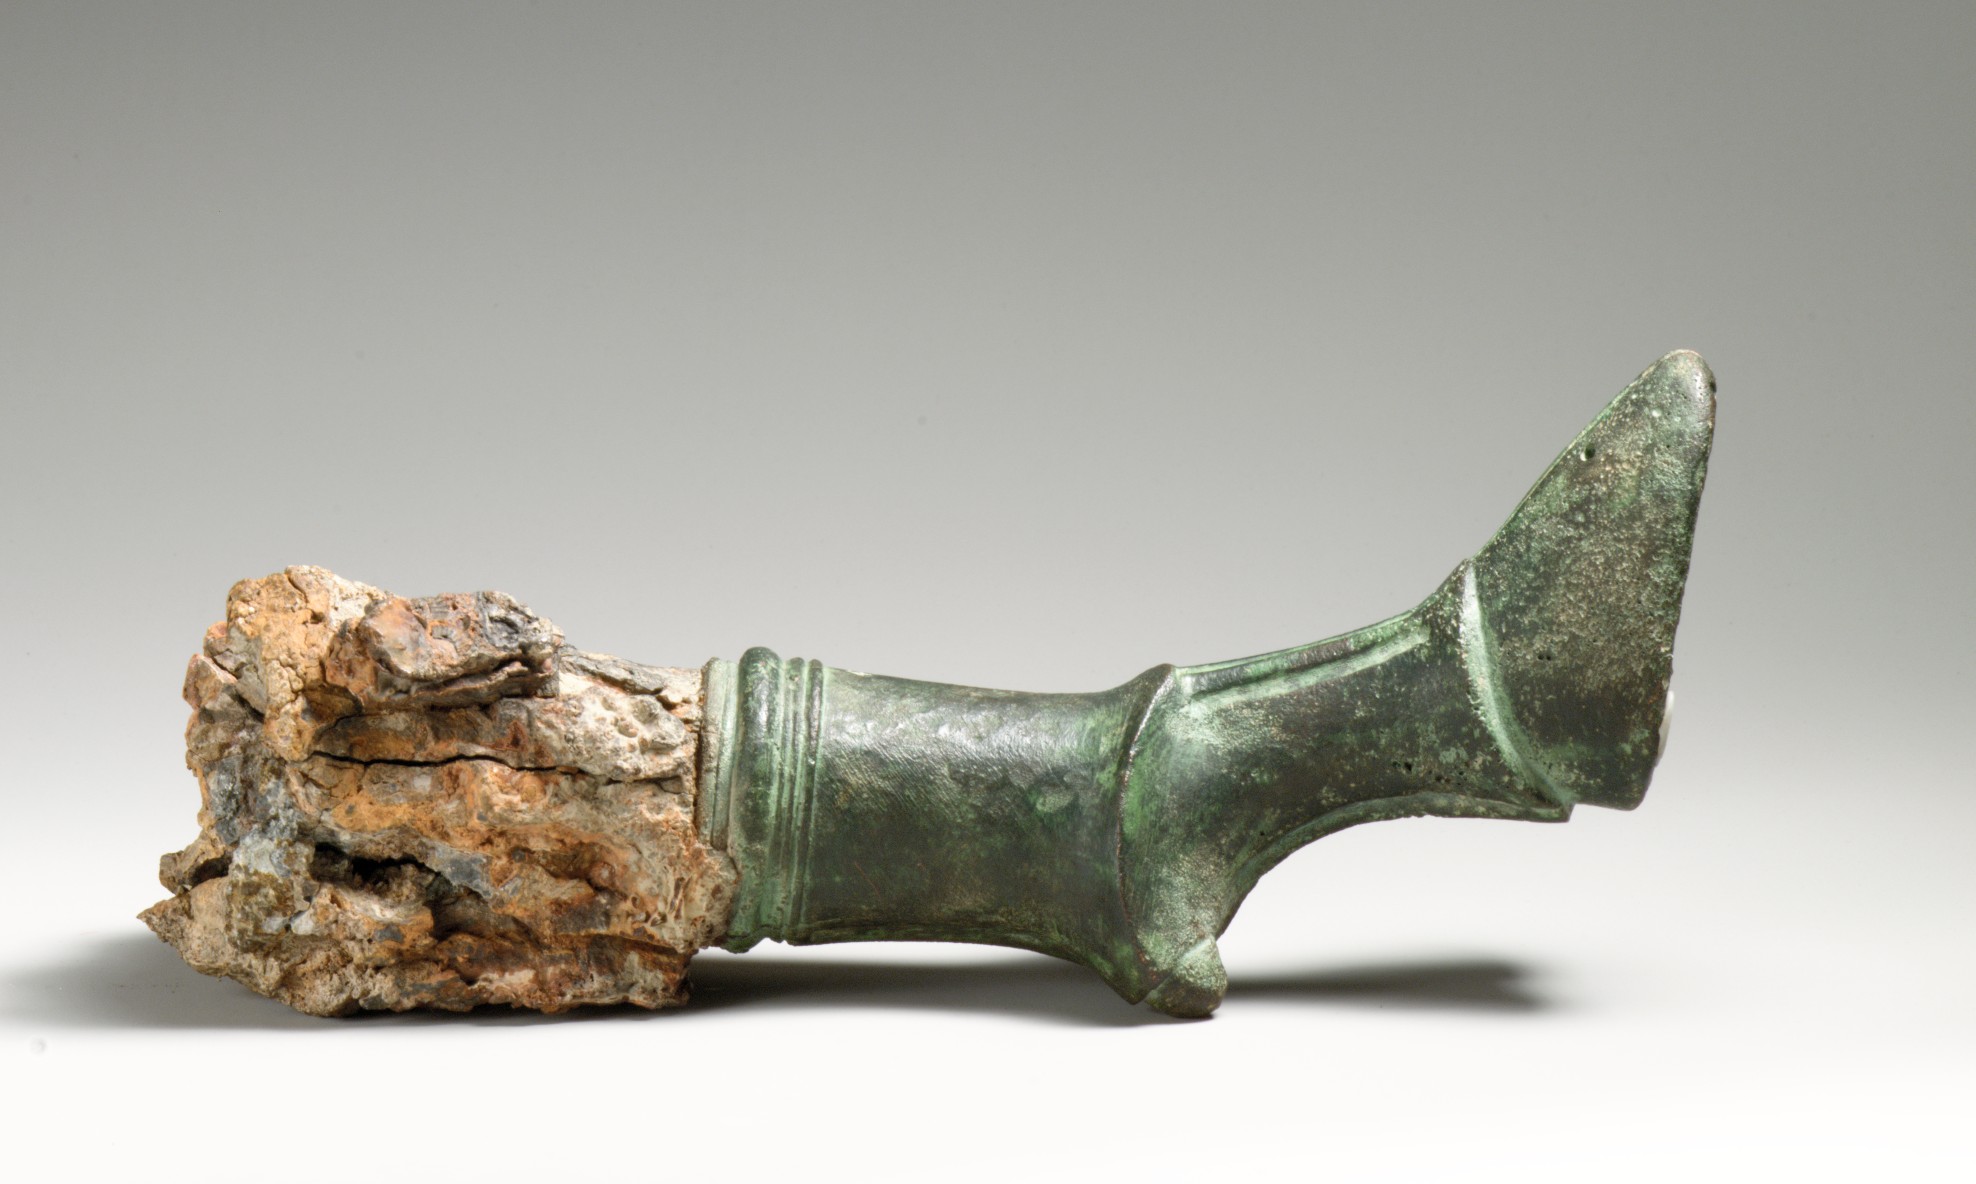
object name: attachment in the form of a hoof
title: Bronze hoof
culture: cypriot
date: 700-668 BCE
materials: bronze